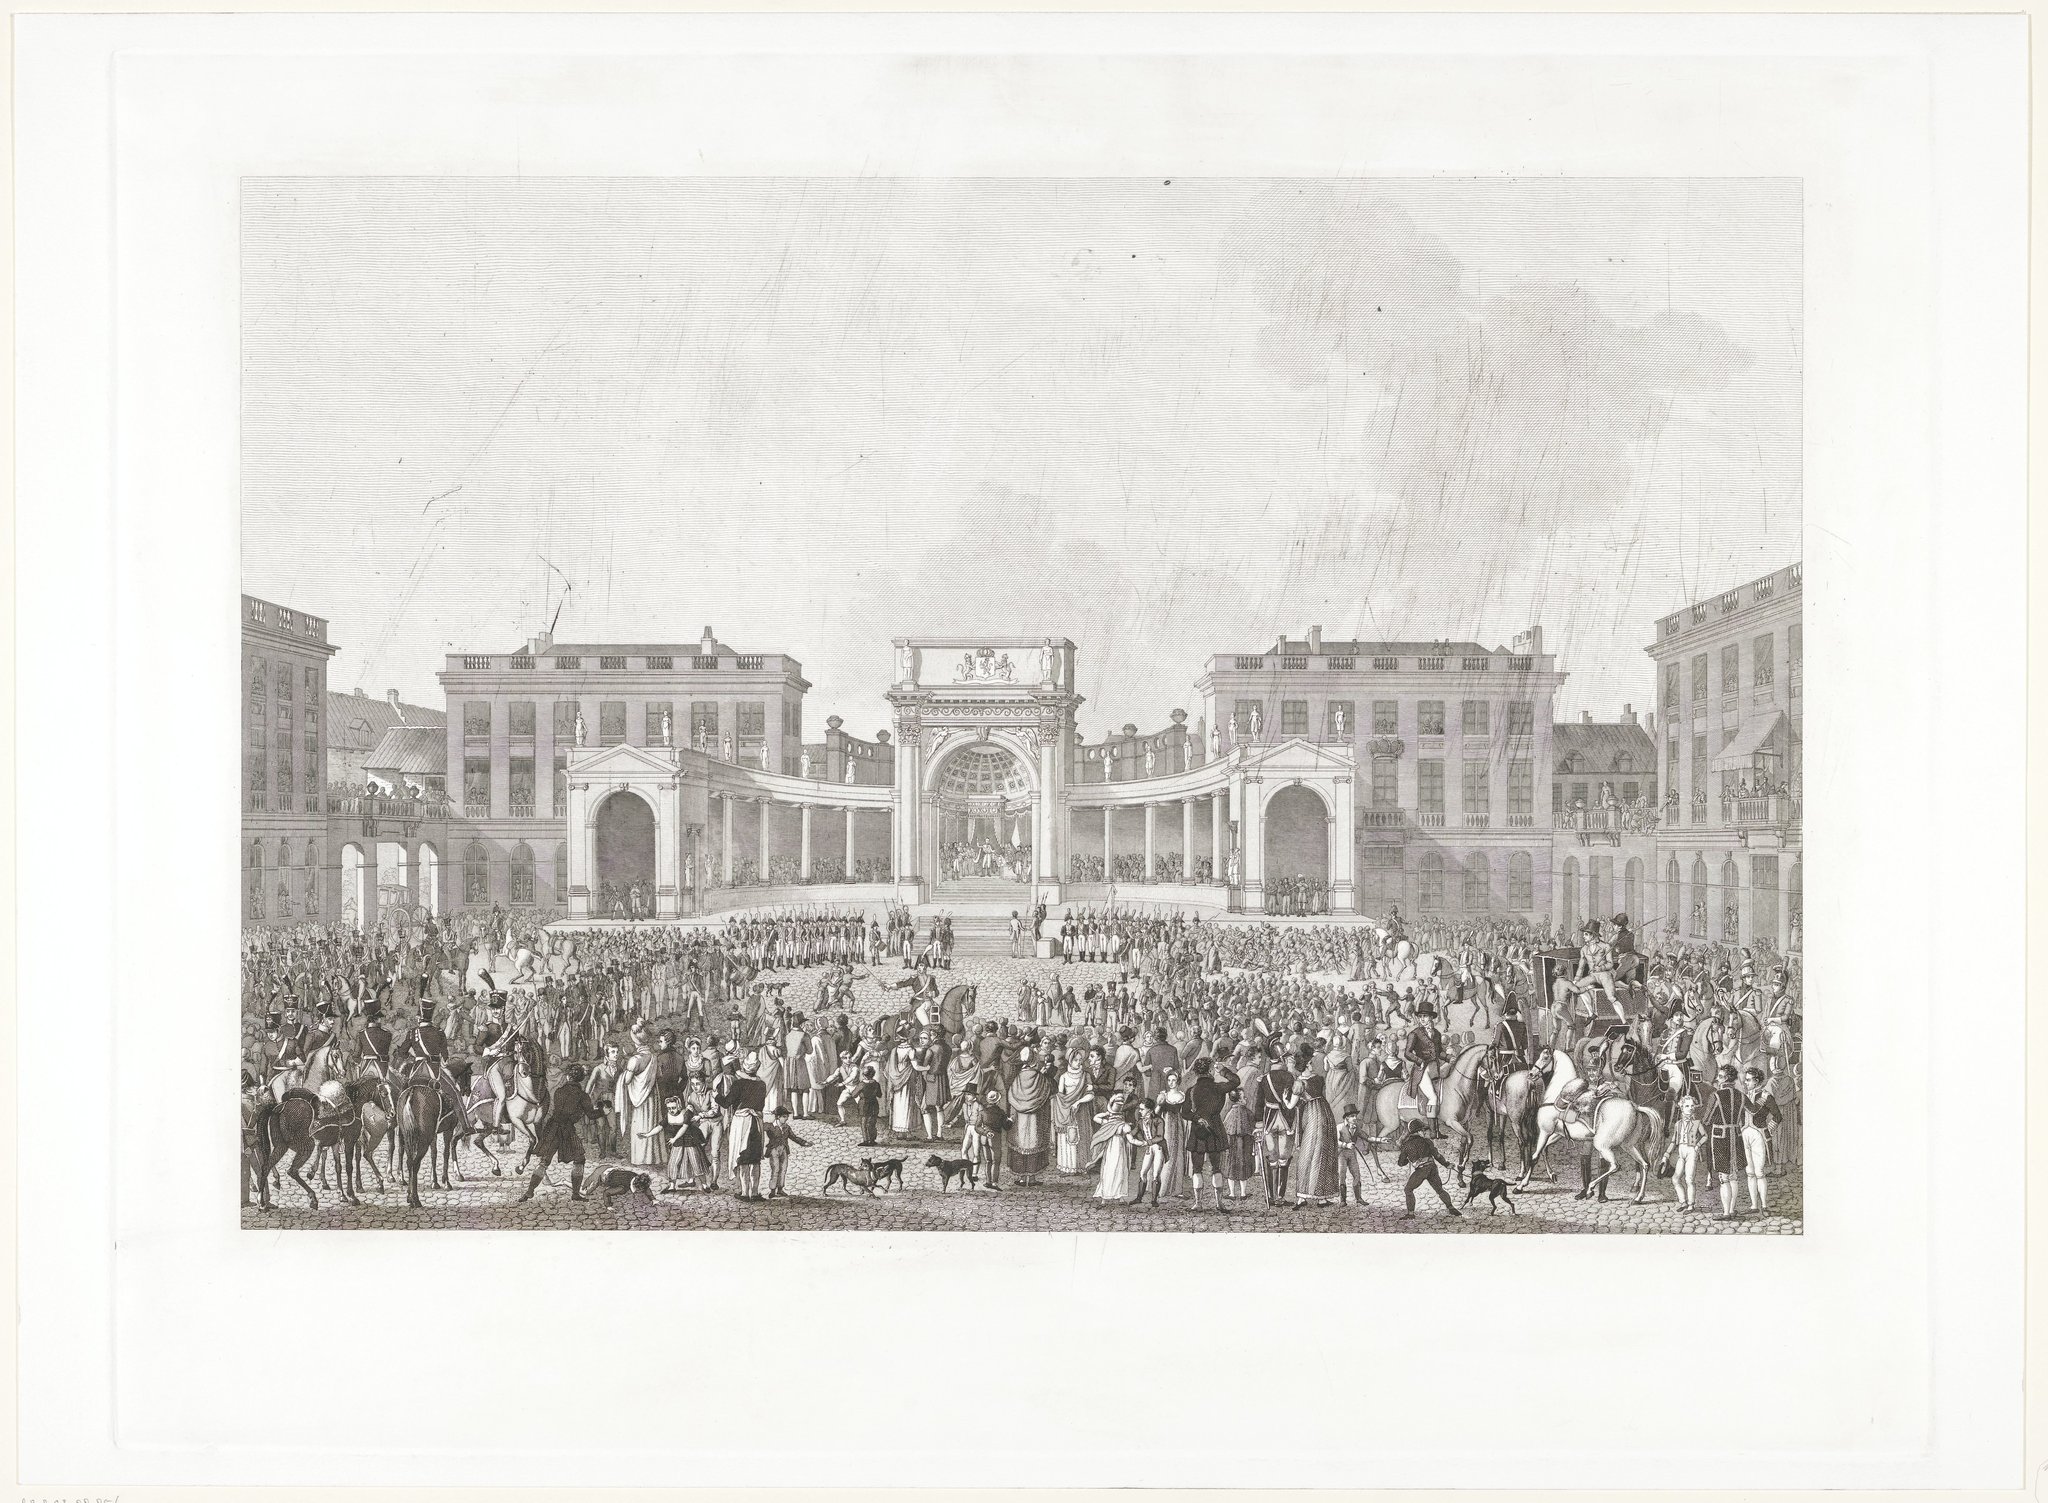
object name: history print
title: Inhuldiging van Willem I te Brussel op 21 september 1815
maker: jacob ernst marcus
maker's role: draughtsman, print maker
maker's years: 1774-1826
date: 1826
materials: paper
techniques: engraving, etching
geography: brussels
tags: the hague, berlin, william i of the netherlands, new ruler taking the oath, brussels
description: Inhuldiging van koning Willem I te Brussel op 21 september 1815. Staande op een platform in de open lucht legt de koning ten overstaan van het publiek de eed af. De voorstelling is bekrast.